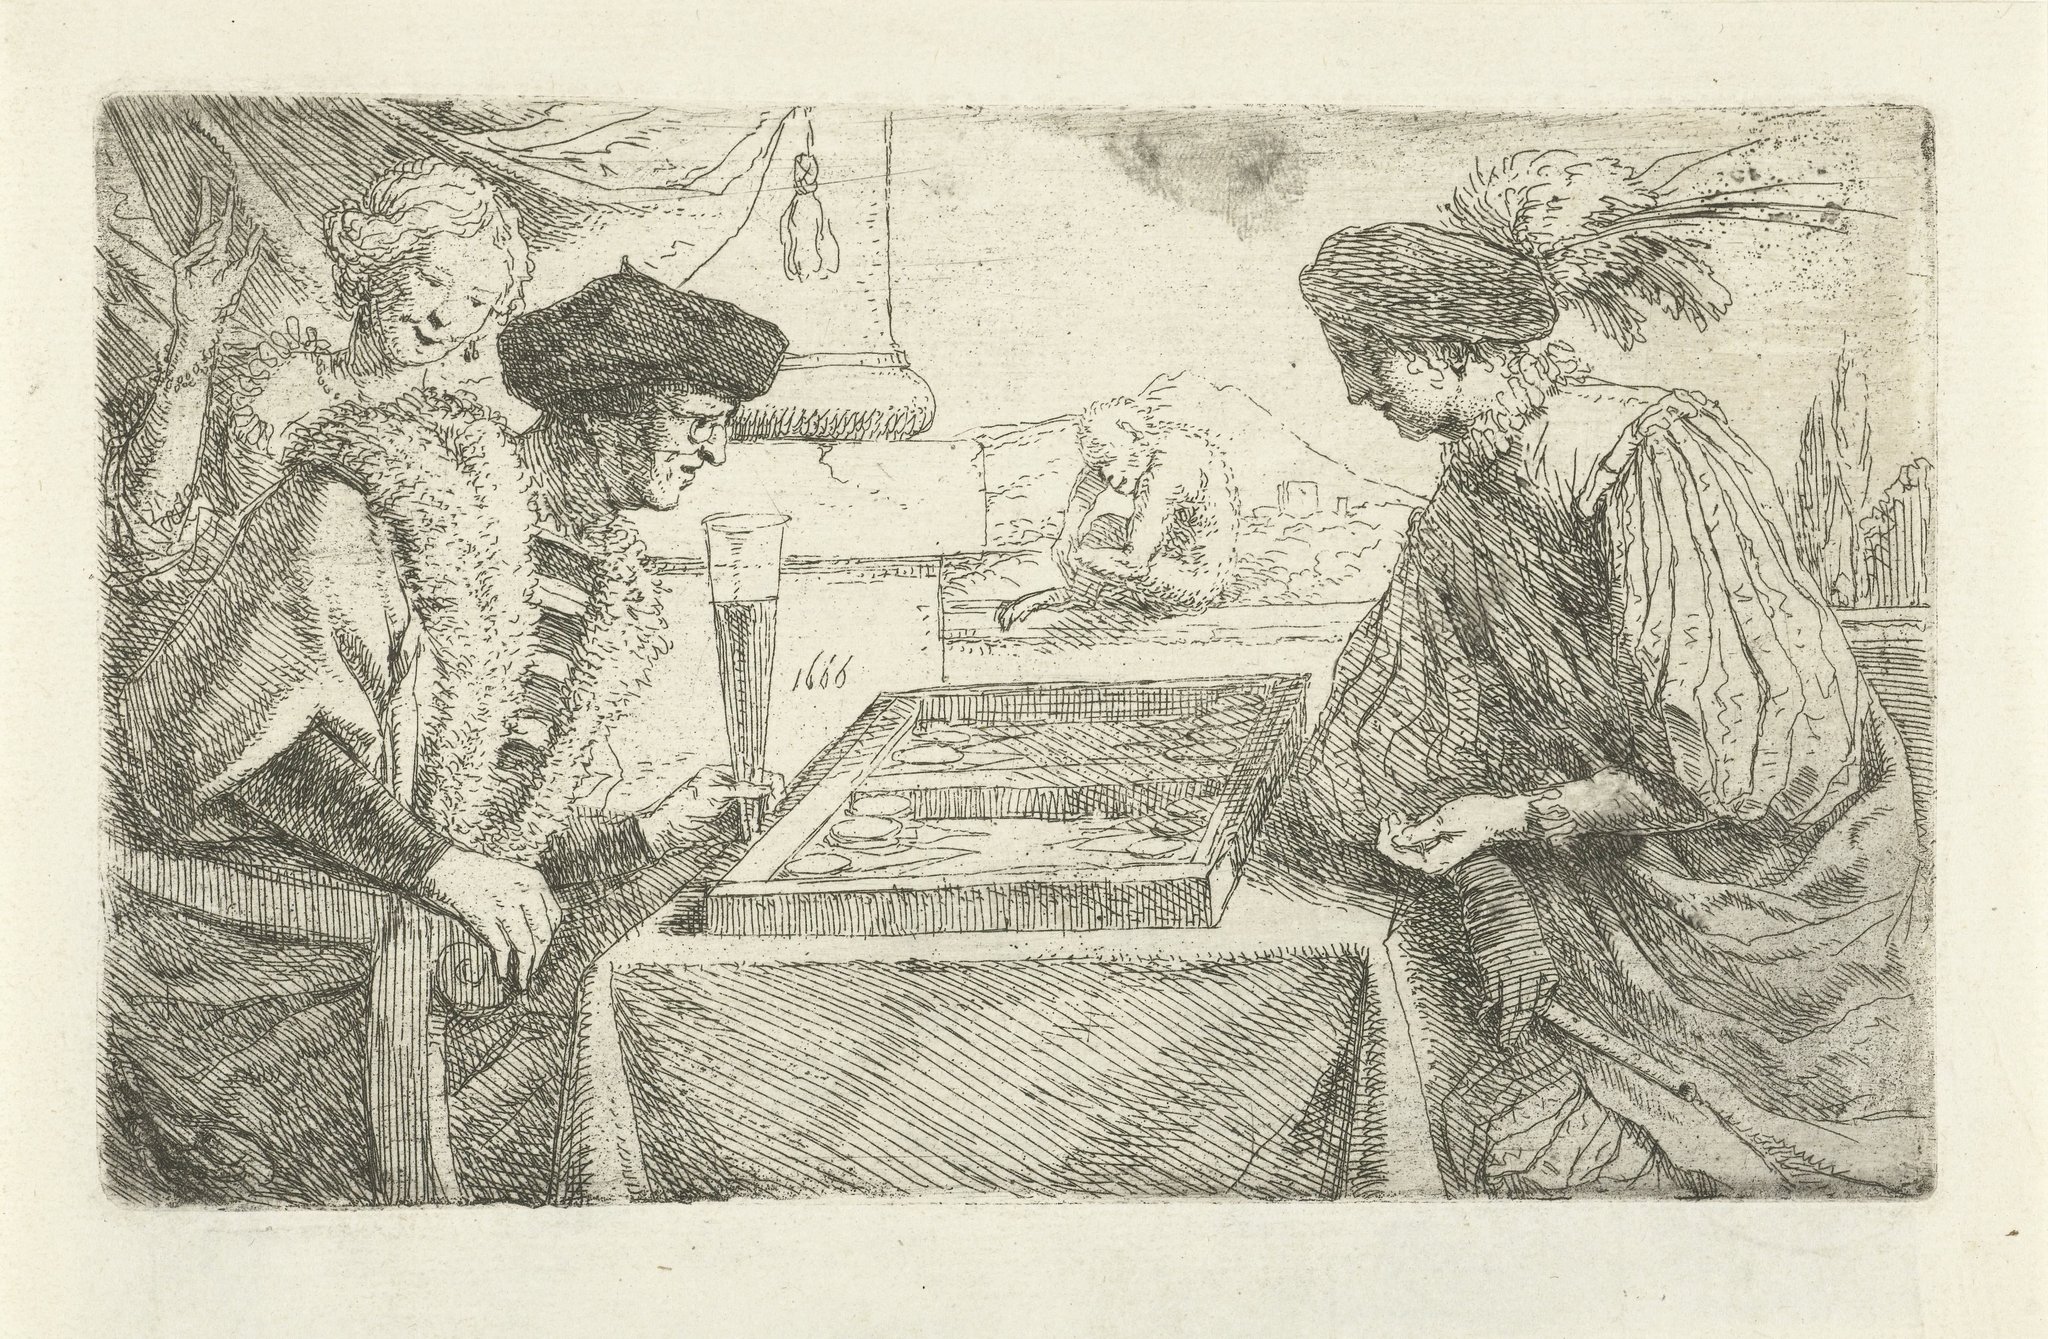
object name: print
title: Twee mannen spelen triktrak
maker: leendert van der cooghen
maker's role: draughtsman, print maker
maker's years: 1632-1681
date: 1666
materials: paper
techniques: etching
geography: haarlem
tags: inn, coffee-house, public house, etc., backgammon, tric-trac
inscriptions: collector's mark: Lugt 240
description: Twee mannen zitten in een kroeg aan een tafel en spelen triktrak. Een dame kijkt over de schouder van de man links mee. In het raam zit een aapje. De linker man is ouder, draagt een jas die is afgezet met bont en houdt een drinkglas vast. De rechter man is jonger, hij draagt een opvallende hoed met veren.